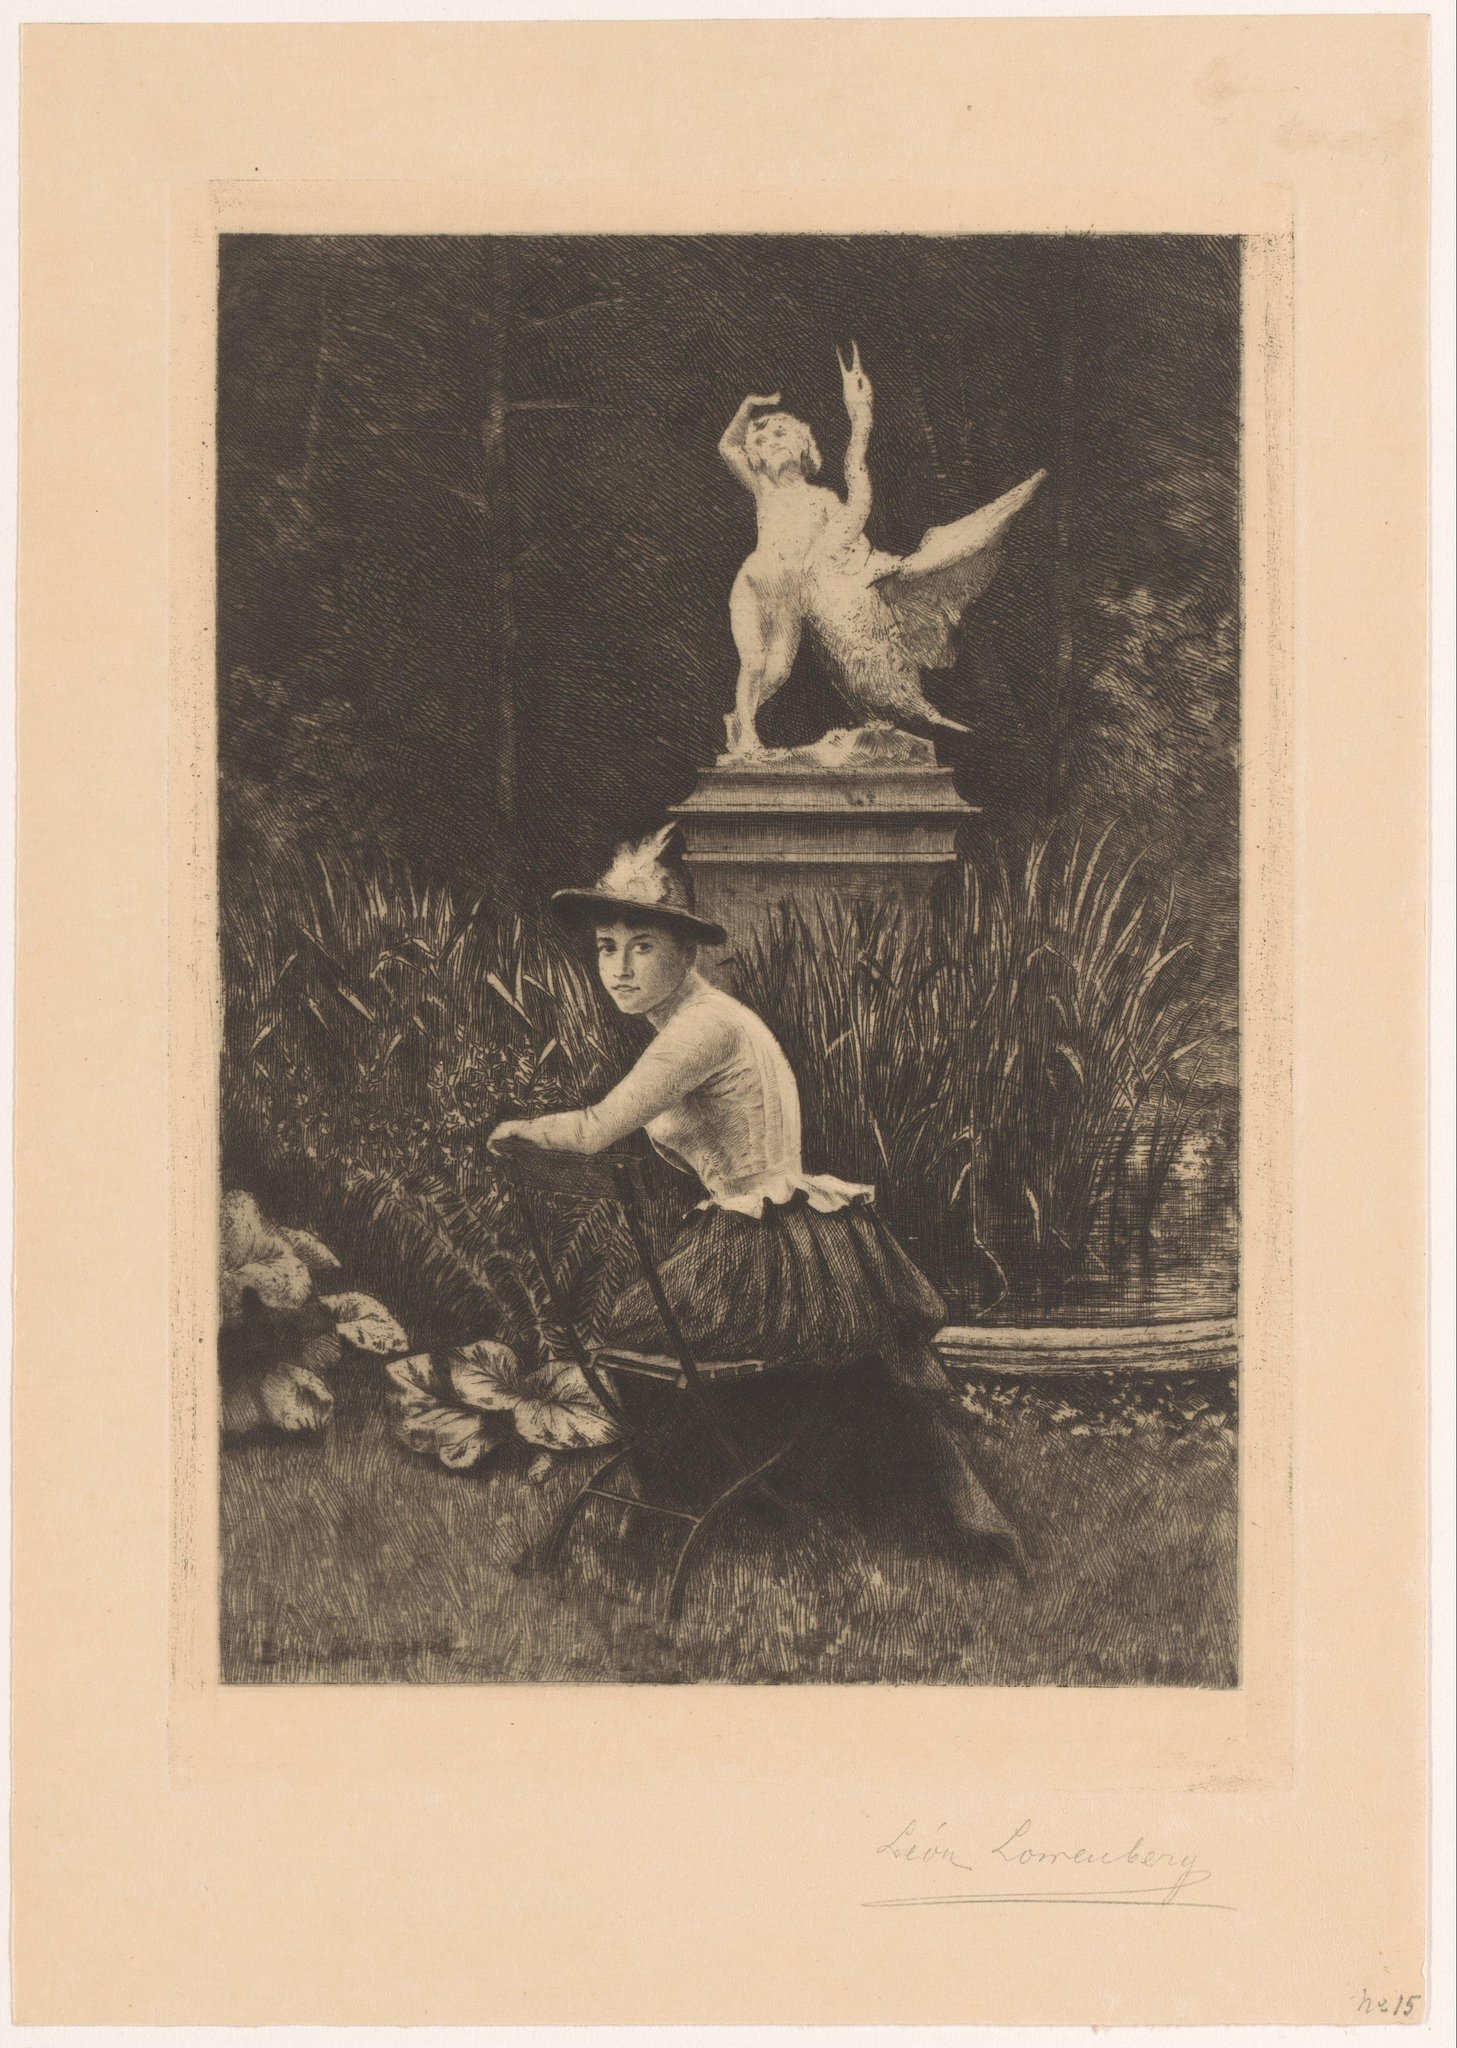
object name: print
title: Vrouw op een stoel in de tuin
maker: léon lowenberg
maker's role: print maker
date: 1875-1912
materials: paper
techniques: drypoint, etching, intaglio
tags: adolescent, young woman, maiden, garden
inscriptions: collector's mark: Lugt 2228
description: Geboorte- en sterfdatum van de prentmaker zijn onbekend. Daarom is voor de bepaling van de rechten van dit object gebruik gemaakt van de verwervingsdatum Rijksmuseum Amsterdam.